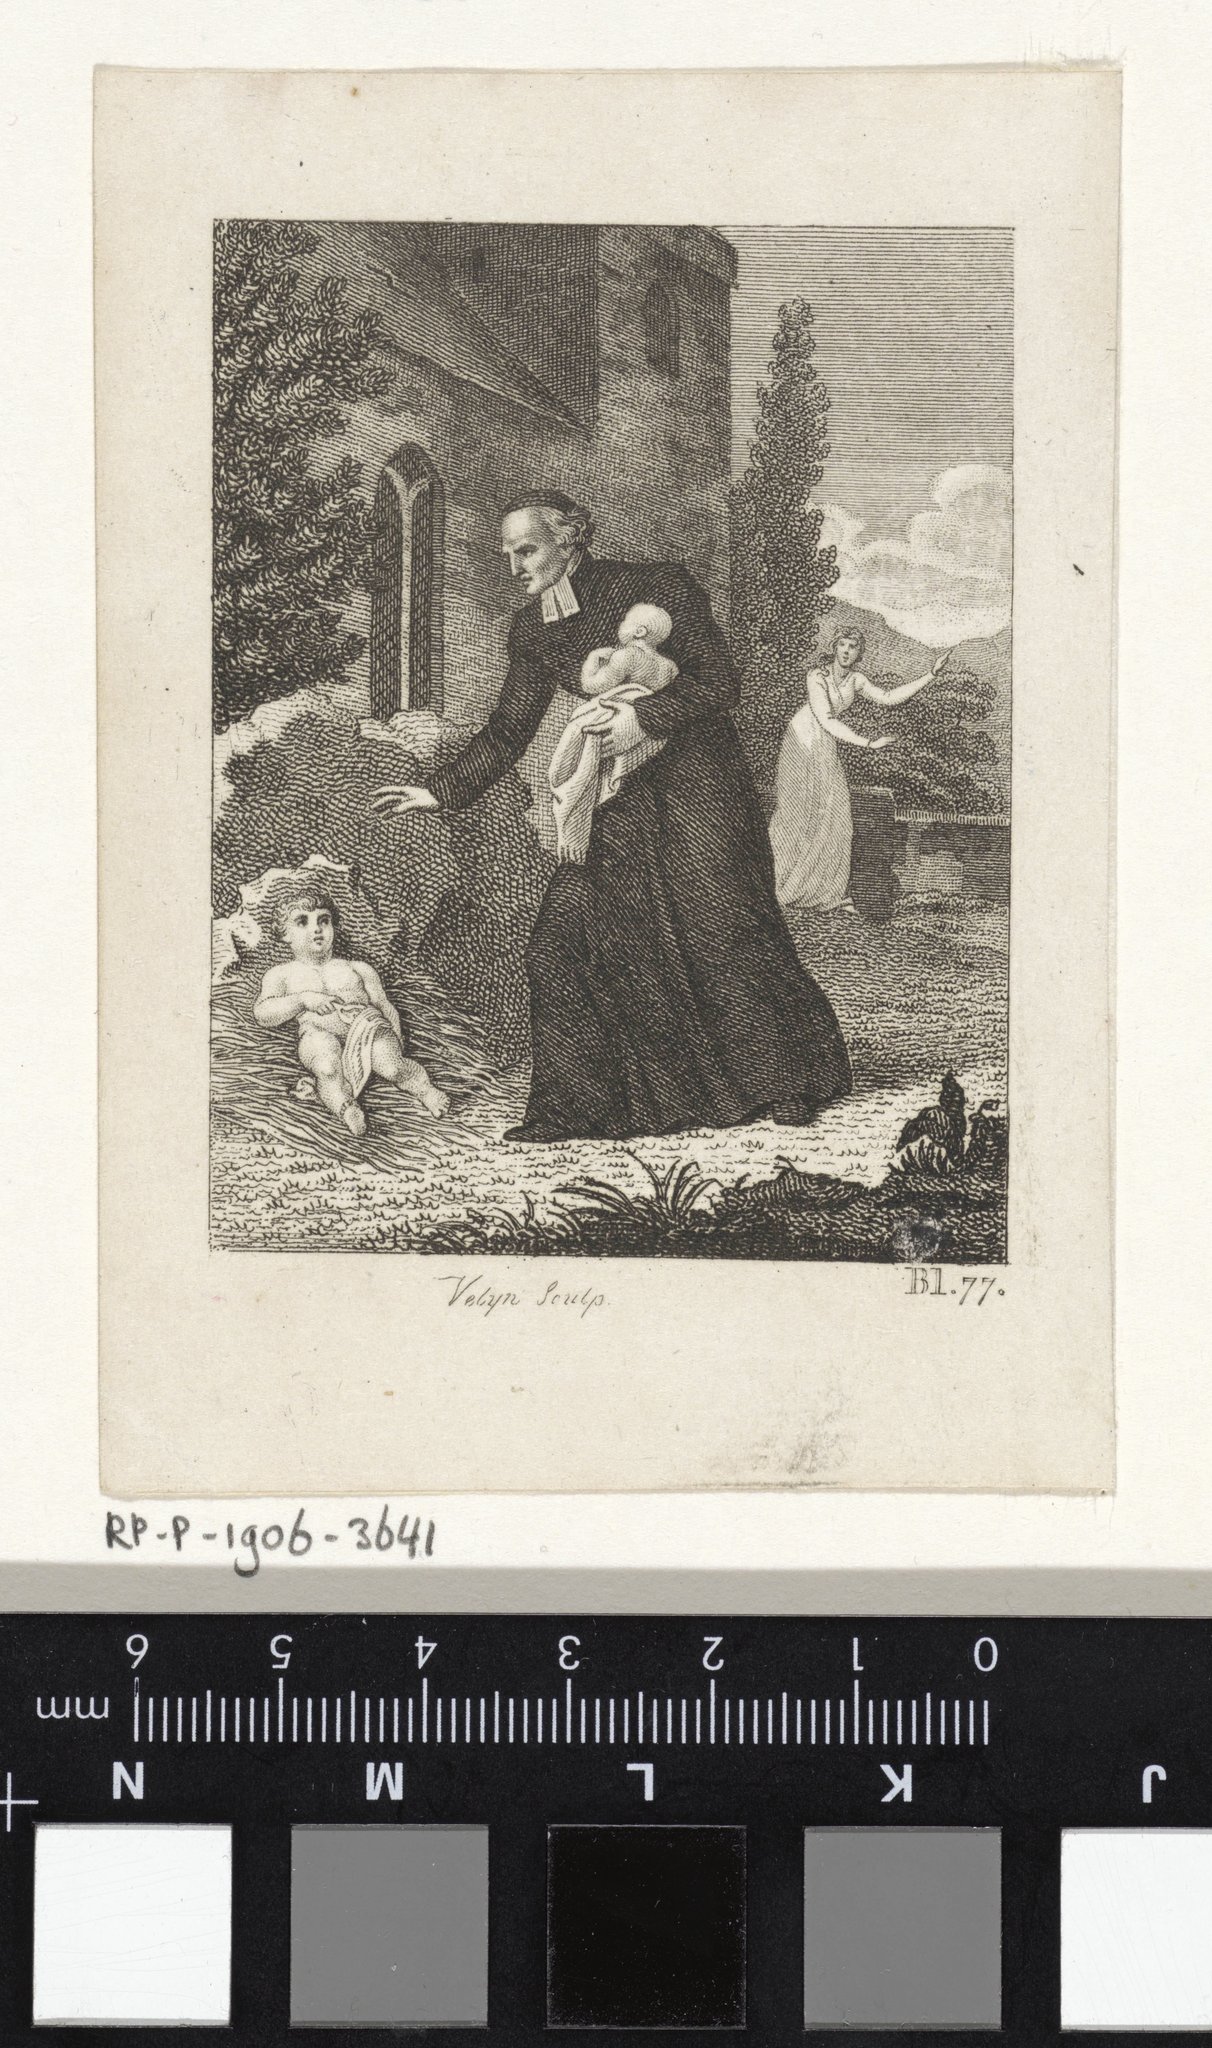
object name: book illustration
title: H. Vincent de Paul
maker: philippus velijn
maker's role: print maker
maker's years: 1787-1836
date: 1821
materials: paper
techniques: etching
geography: netherlands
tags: st. vincent de paul taking care of orphans and foundlings, infant, baby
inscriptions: collector's mark: Lugt 2228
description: De heilige Vincent de Paul zorgt voor wezen en vondelingen. Op de achtergrond komt een vrouw met opgheven armen aangerend. Rechtsonder: bl. 77.